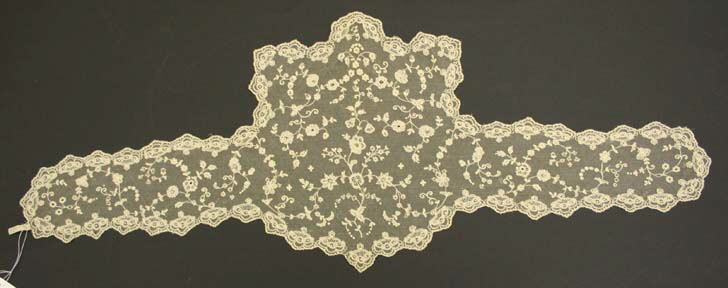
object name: cap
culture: irish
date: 1801-1900